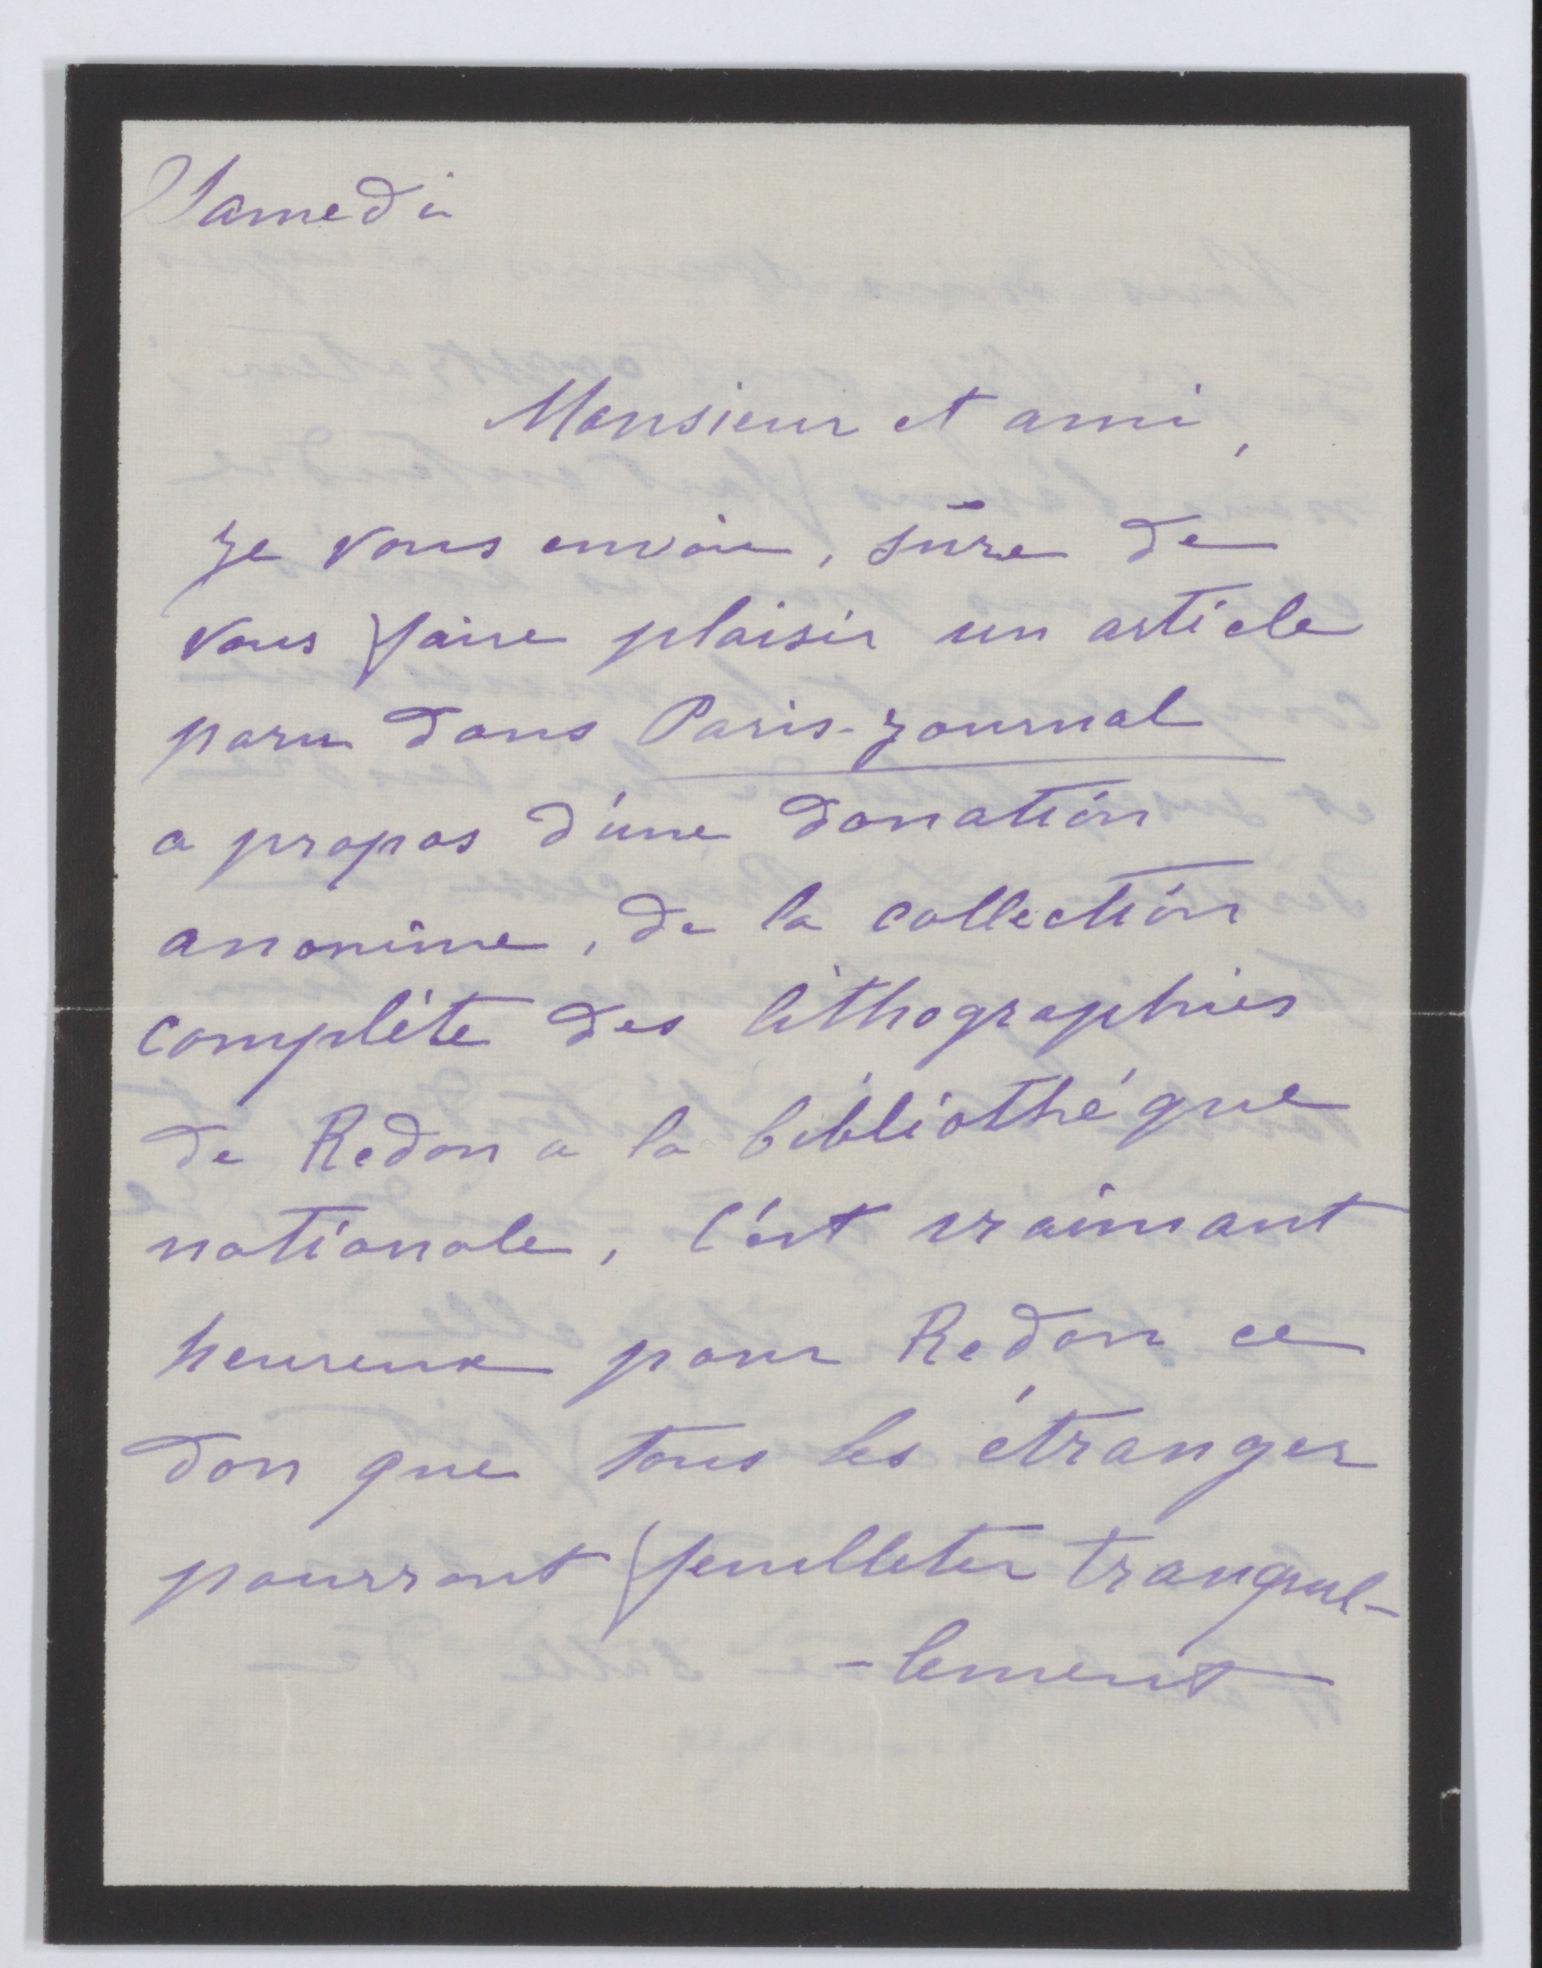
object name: letter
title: Brief aan Andries Bonger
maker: camille redon-falte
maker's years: 1853-1923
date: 1903-1910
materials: ink, paper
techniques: pen, writing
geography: paris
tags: paris, painter, print maker, draughtsman, odilon redon, paul cézanne, amsterdam, andries bonger, the graphic arts, printed matter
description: Brief behoort tot een album samengesteld door weduwe Françoise W.M. Barones van der Borch van Verwolde met afschriften van brieven met betrekking tot (de familie van) Odilon Redon. De brief werd bewaard op pagina 162.